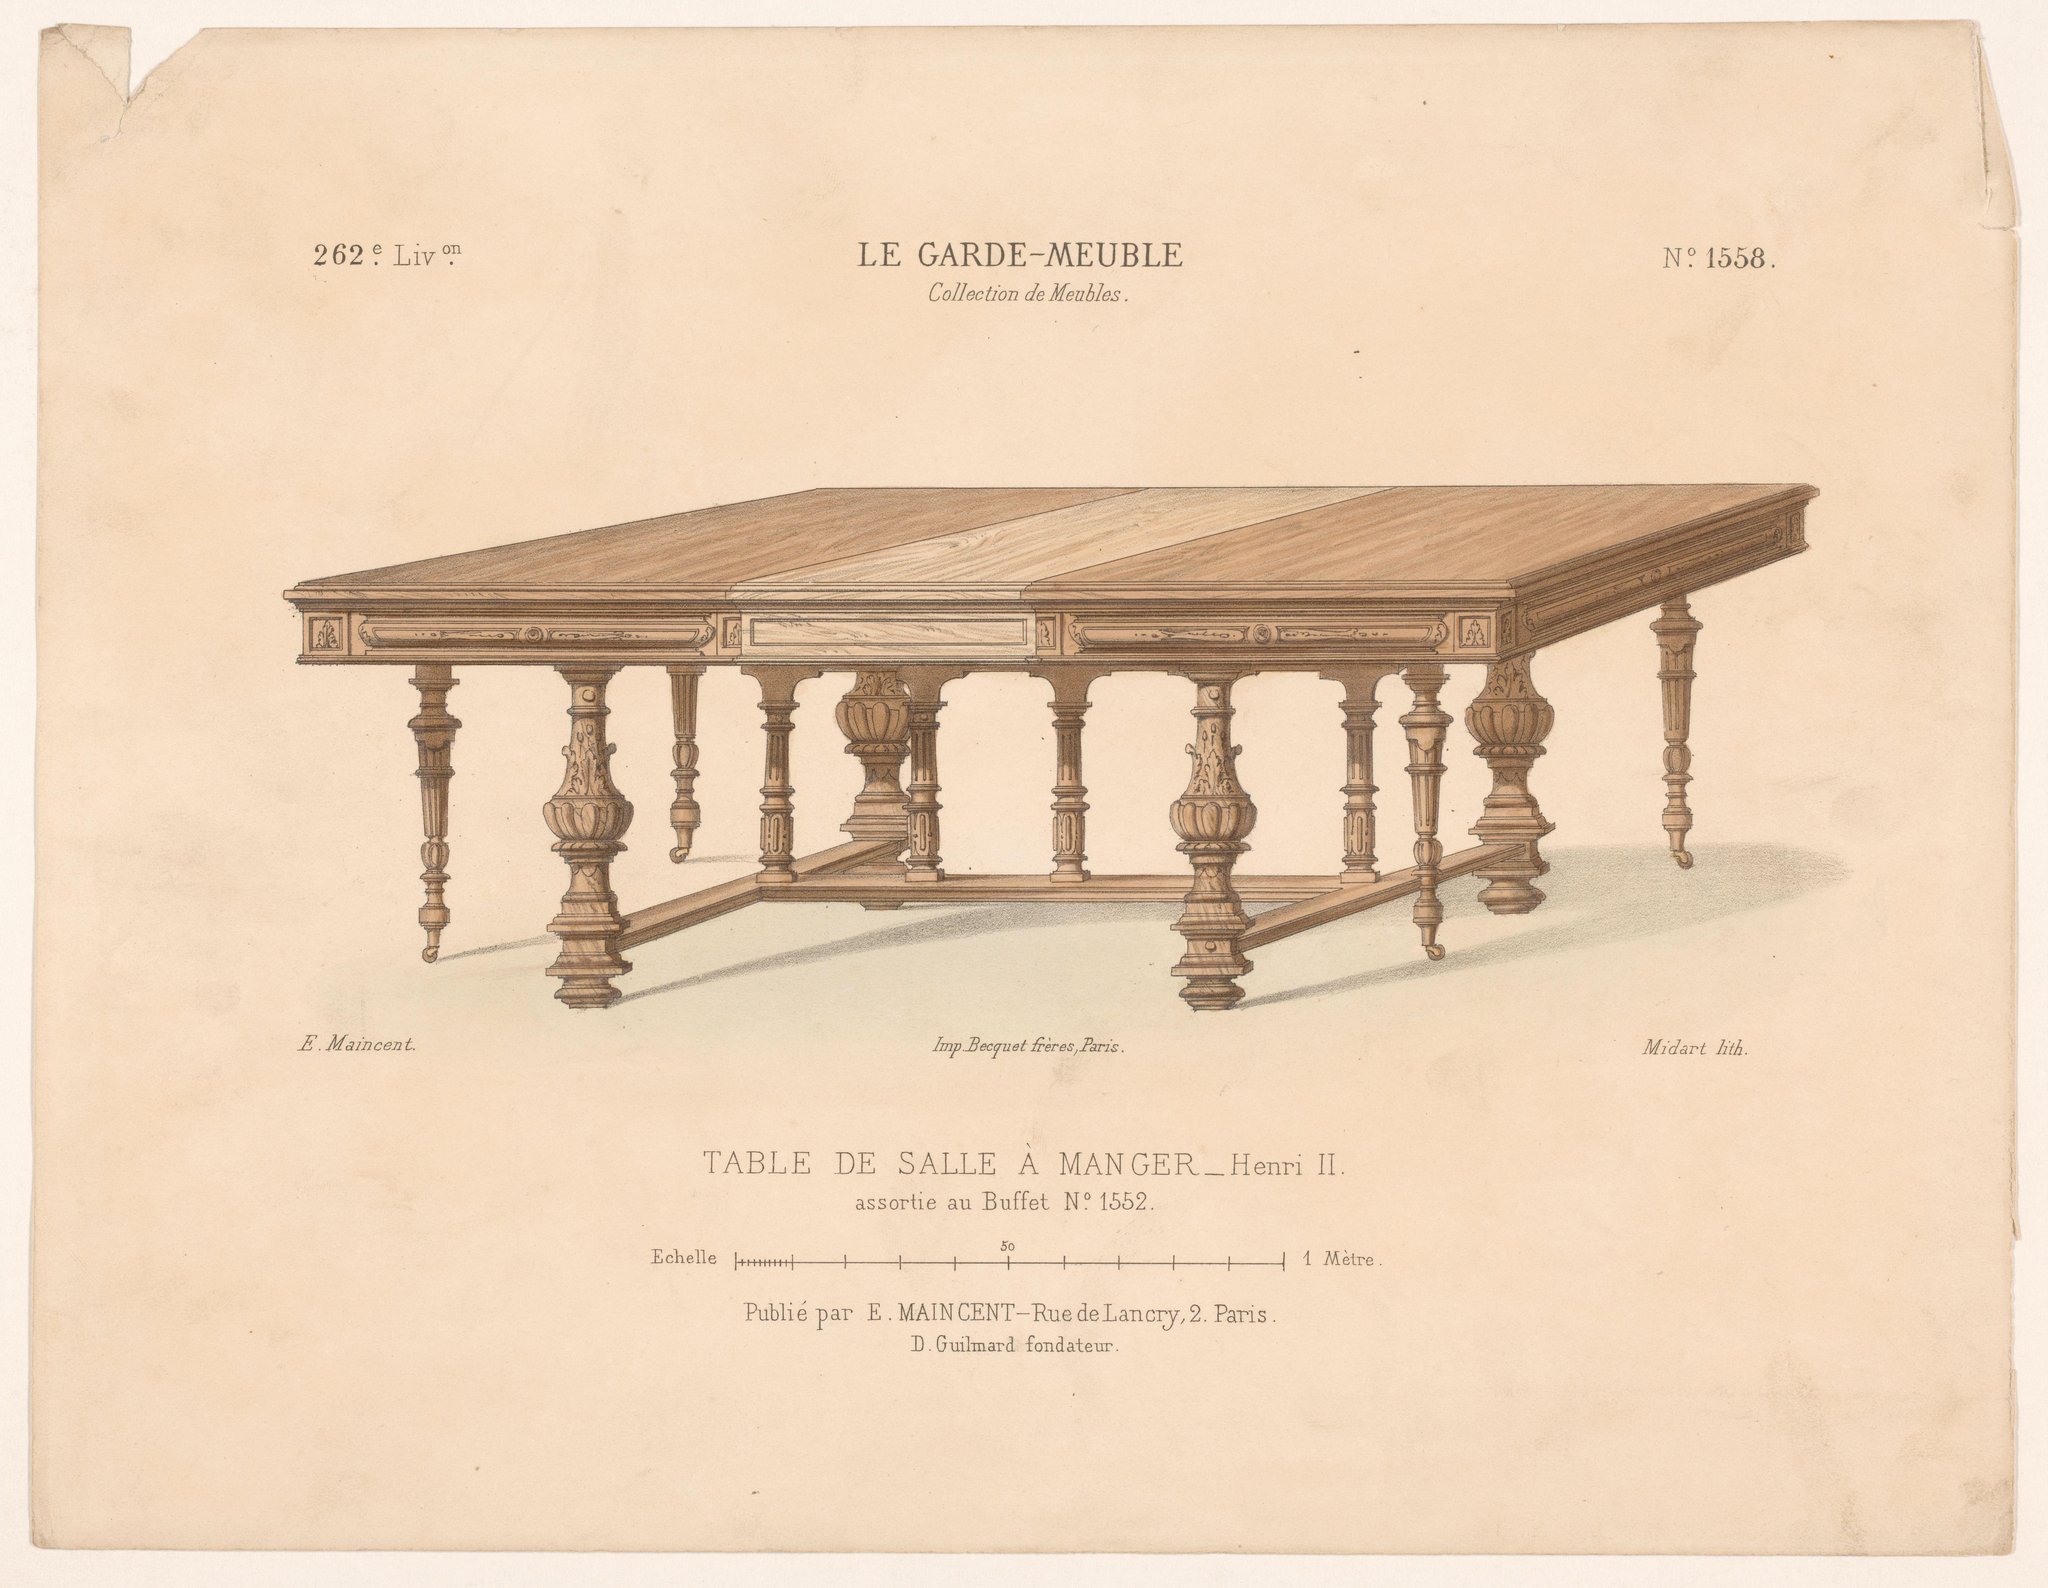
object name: print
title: Table de salle à manger Henri II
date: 1885-1895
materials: paper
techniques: hand coloring, lithograph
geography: paris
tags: table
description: Ieder Livraison in de serie Le Garde-Meuble bevat negen platen: drie 'sièges' (zitmeubels), drie 'meubles' (diverse meubels zoals tafels en kasten) en drie 'tentures' (gordijnen en draperieën).